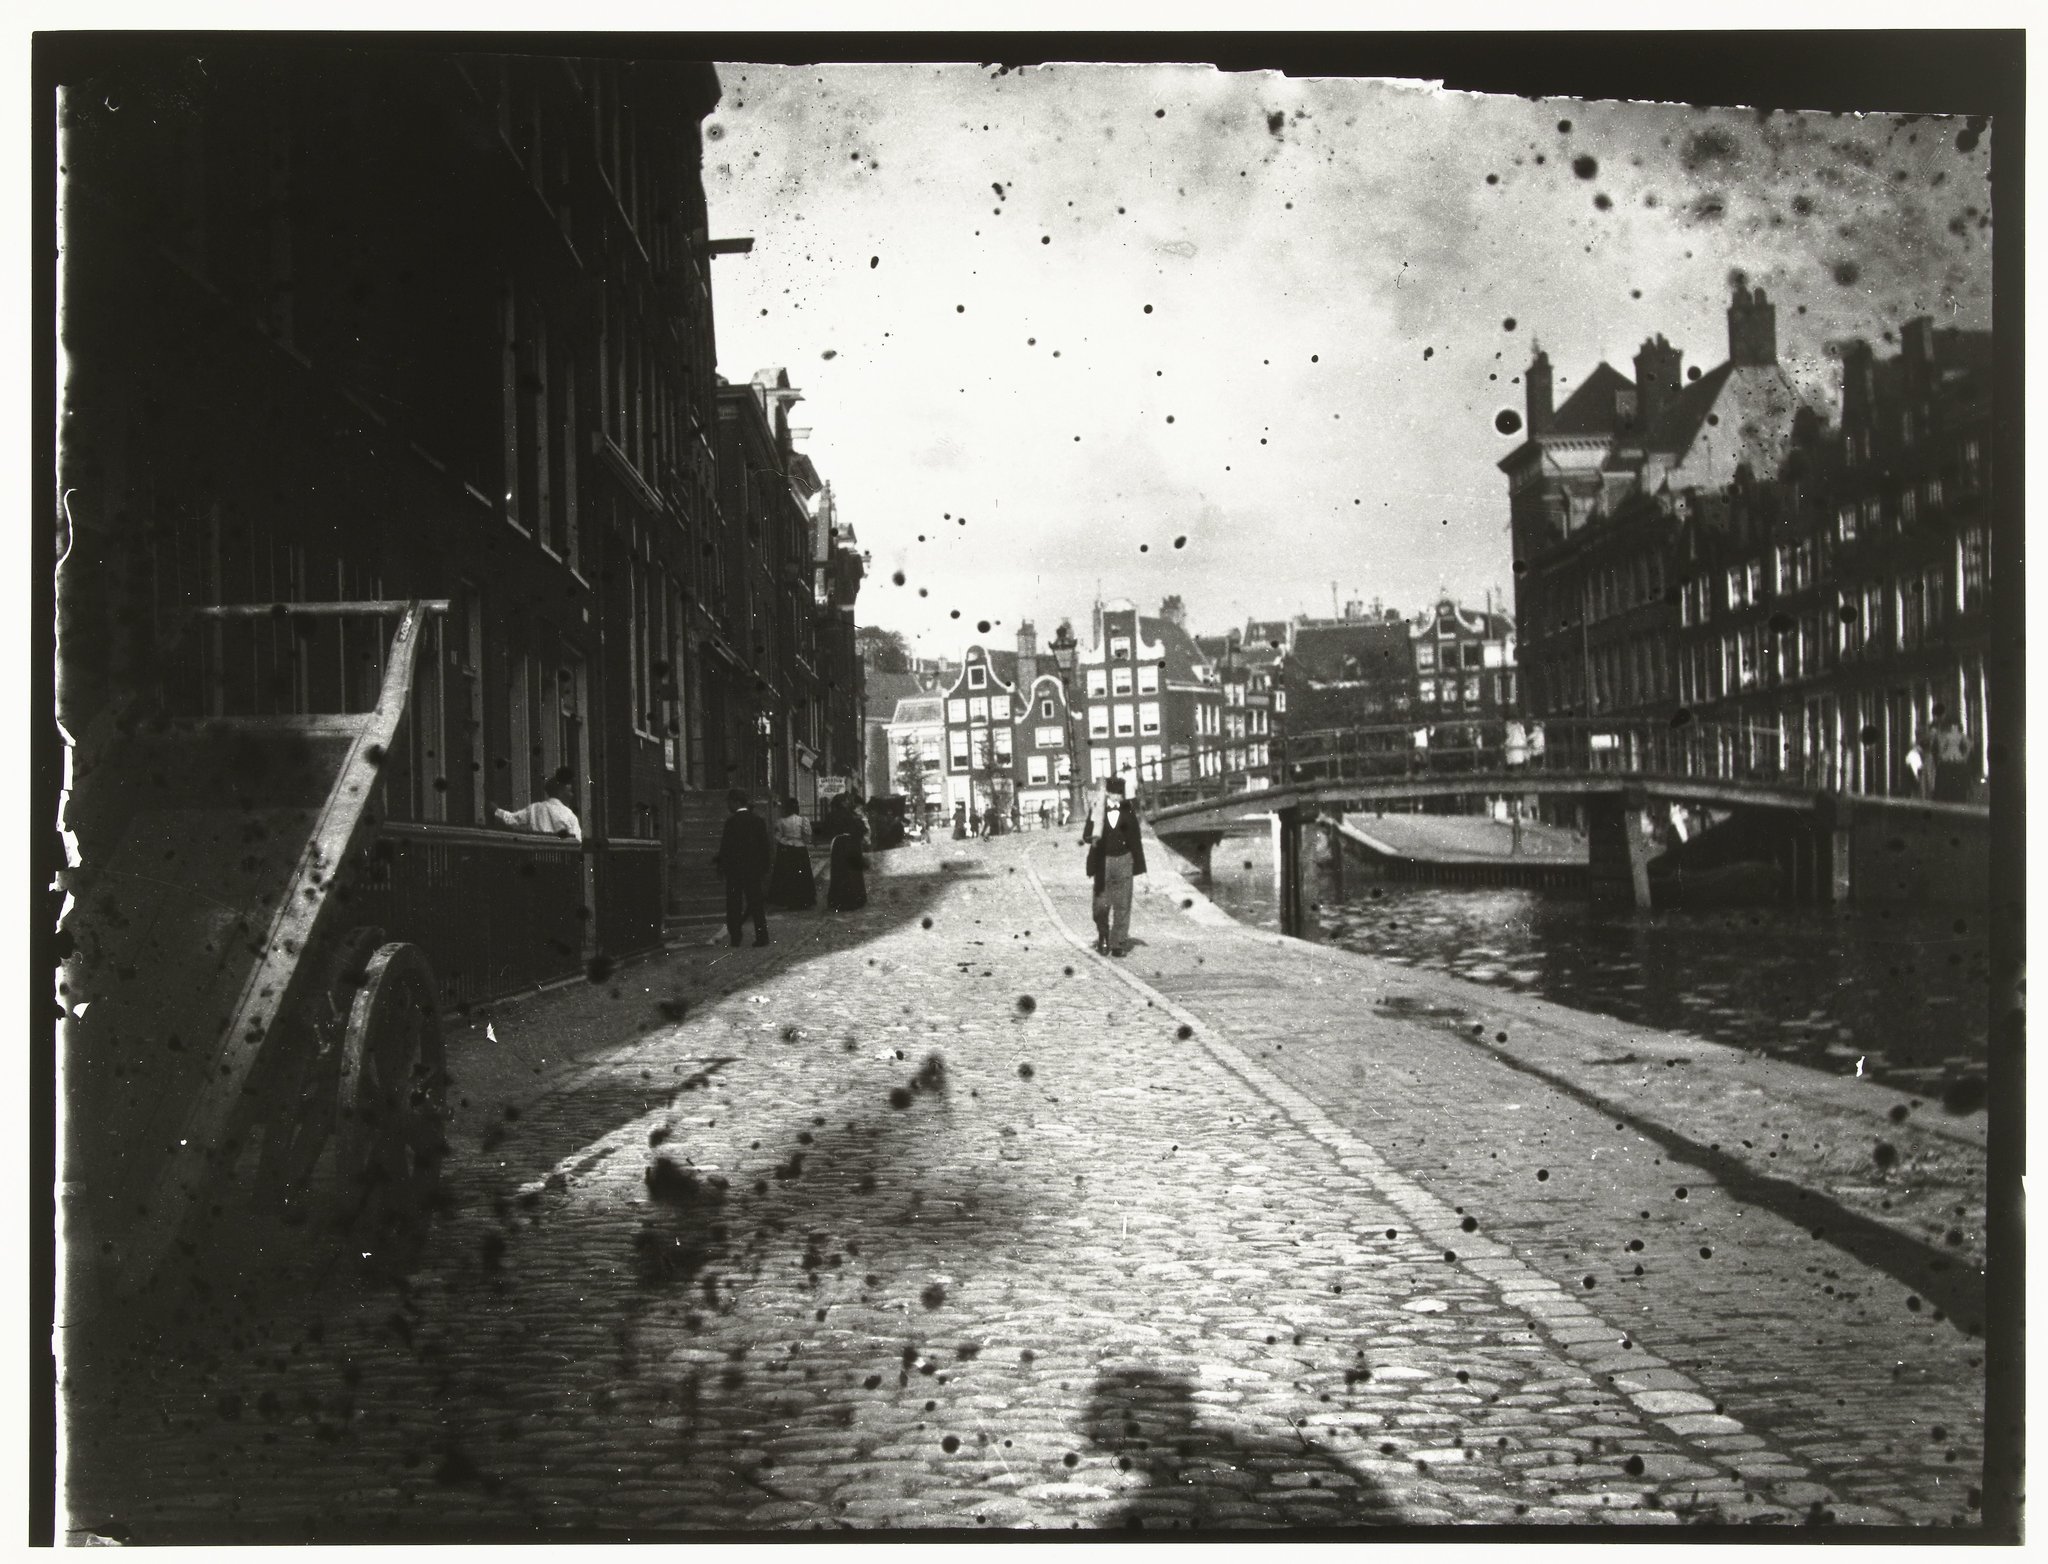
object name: photograph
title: Gezicht op de Looiersgracht in Amsterdam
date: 1890-1910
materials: paper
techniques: gelatin silver print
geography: amsterdam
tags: looiersgracht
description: Moderne afdruk van negatief BR 1826 (collectie RKD).